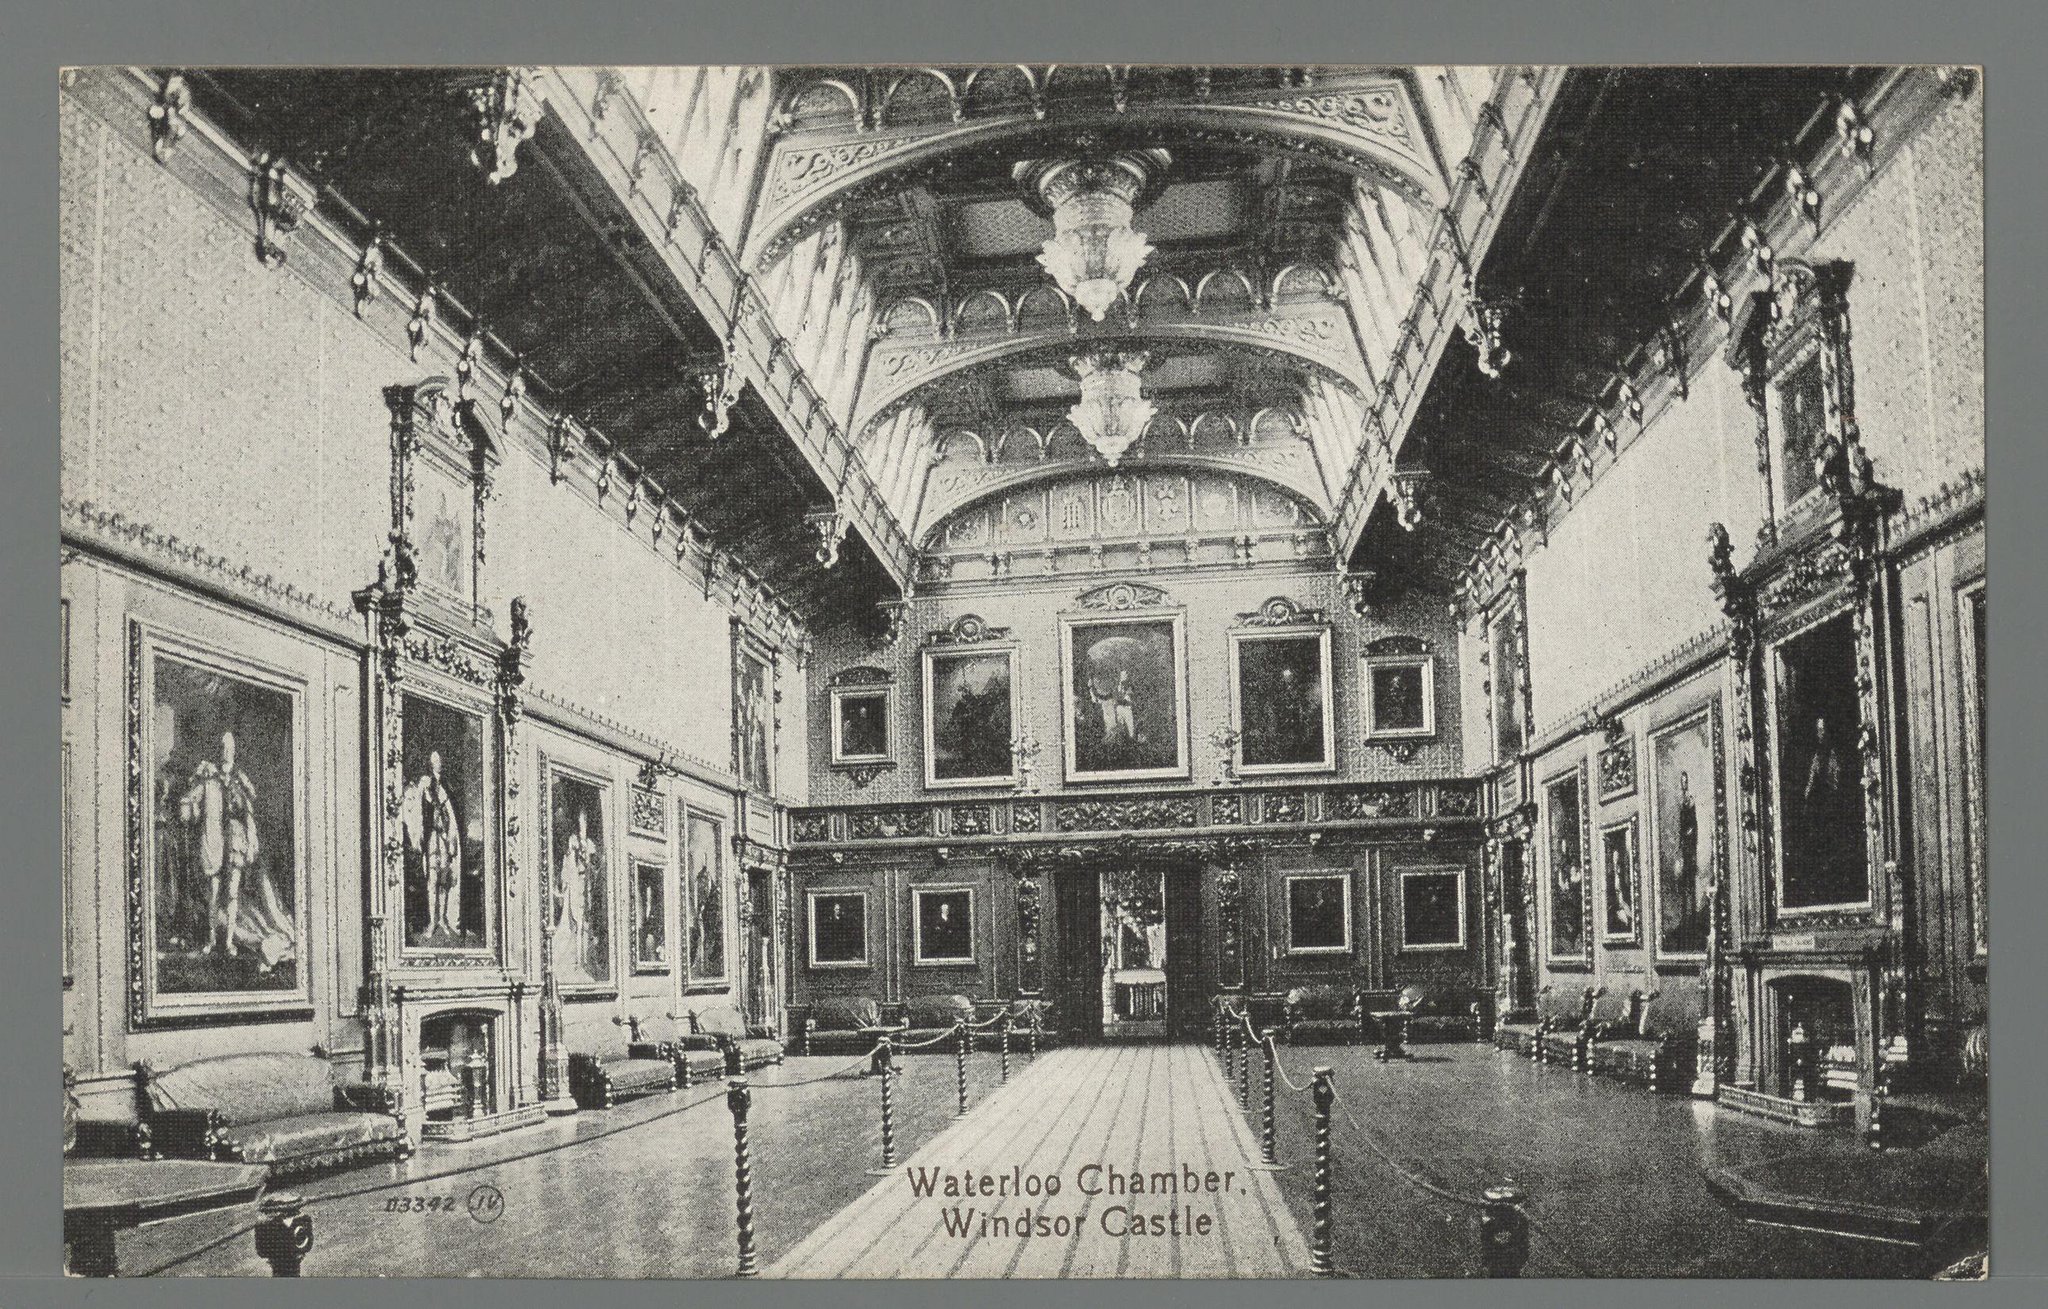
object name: photomechanical print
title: Waterloo Chamber, Windsor Castle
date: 1902-1930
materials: cardboard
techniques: autotype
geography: great britain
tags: castle, interior of the house